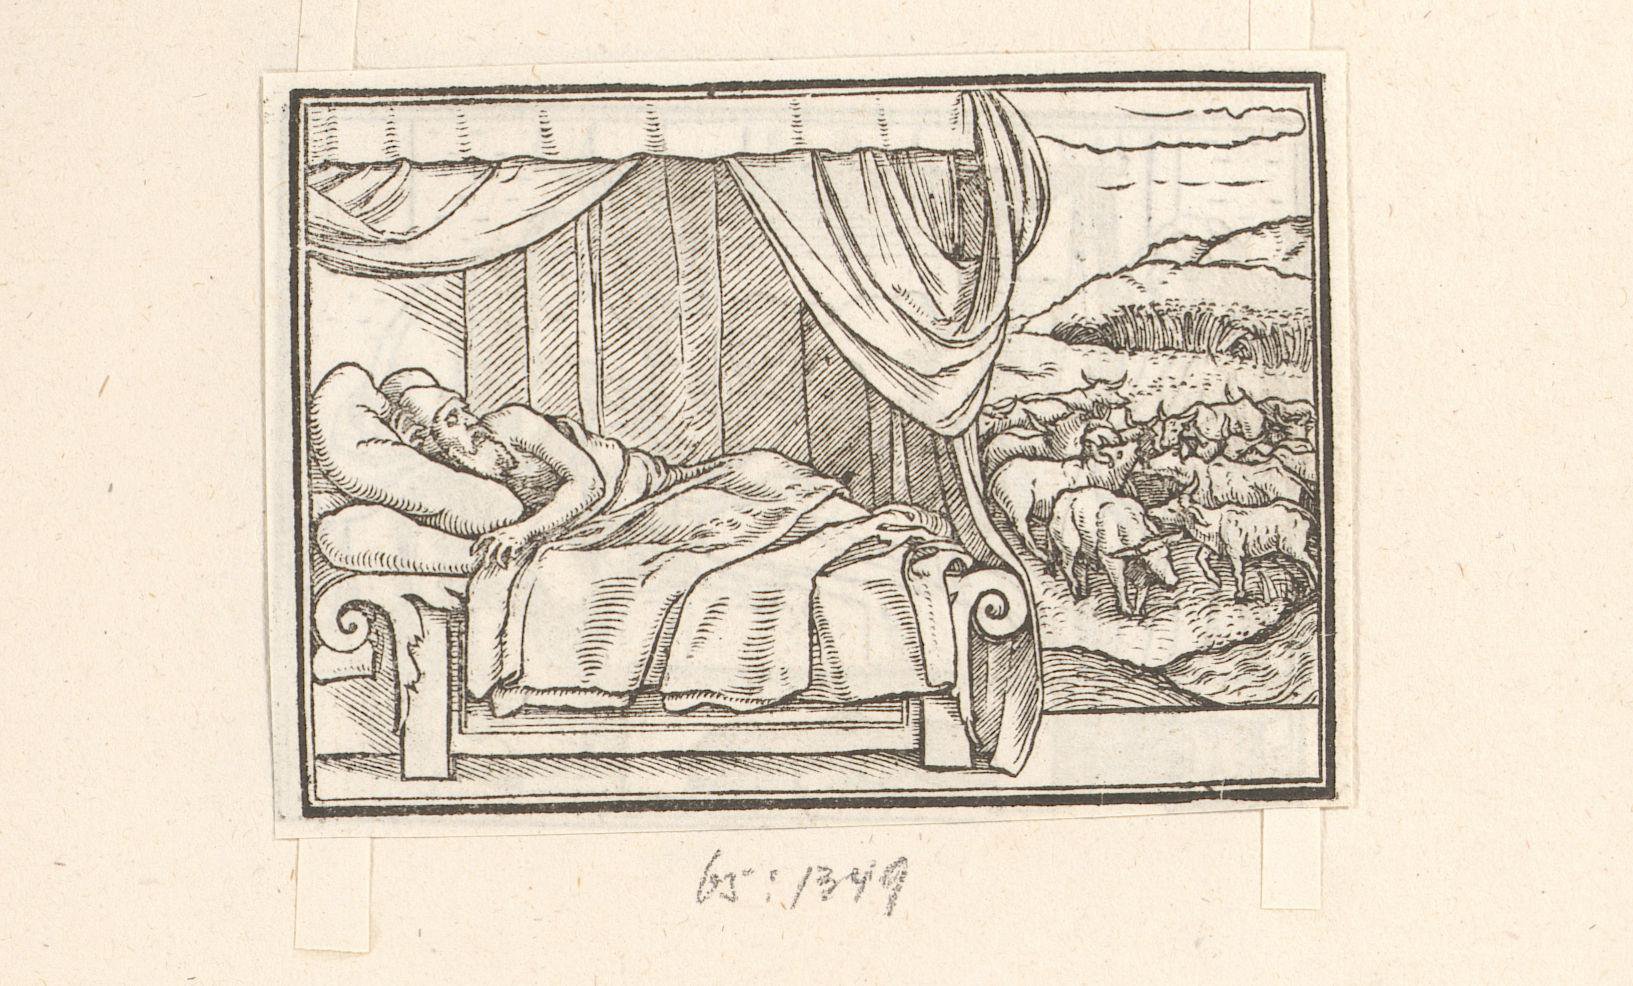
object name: print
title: Geschiedenis van het Oude Testament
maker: veit rudolf specklin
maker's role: print maker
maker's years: -1550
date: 1538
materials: paper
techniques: woodcut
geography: switzerland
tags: pharaoh's dreams ~ story of joseph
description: Boekillustratie voor het eerst gebruikt in: Biblia Utriusque Testamenti iuxta Vulgatam Translationem, Lyon, M. en G. Trechsel (voor Hugo à Porta) 1538. Later in verschillende uitgaven opnieuw gebruikt. Deze prent vermoedelijk gebruikt in één van de uitgaven uitgegeven en/of gedrukt door Jean Frellon, Lyon.